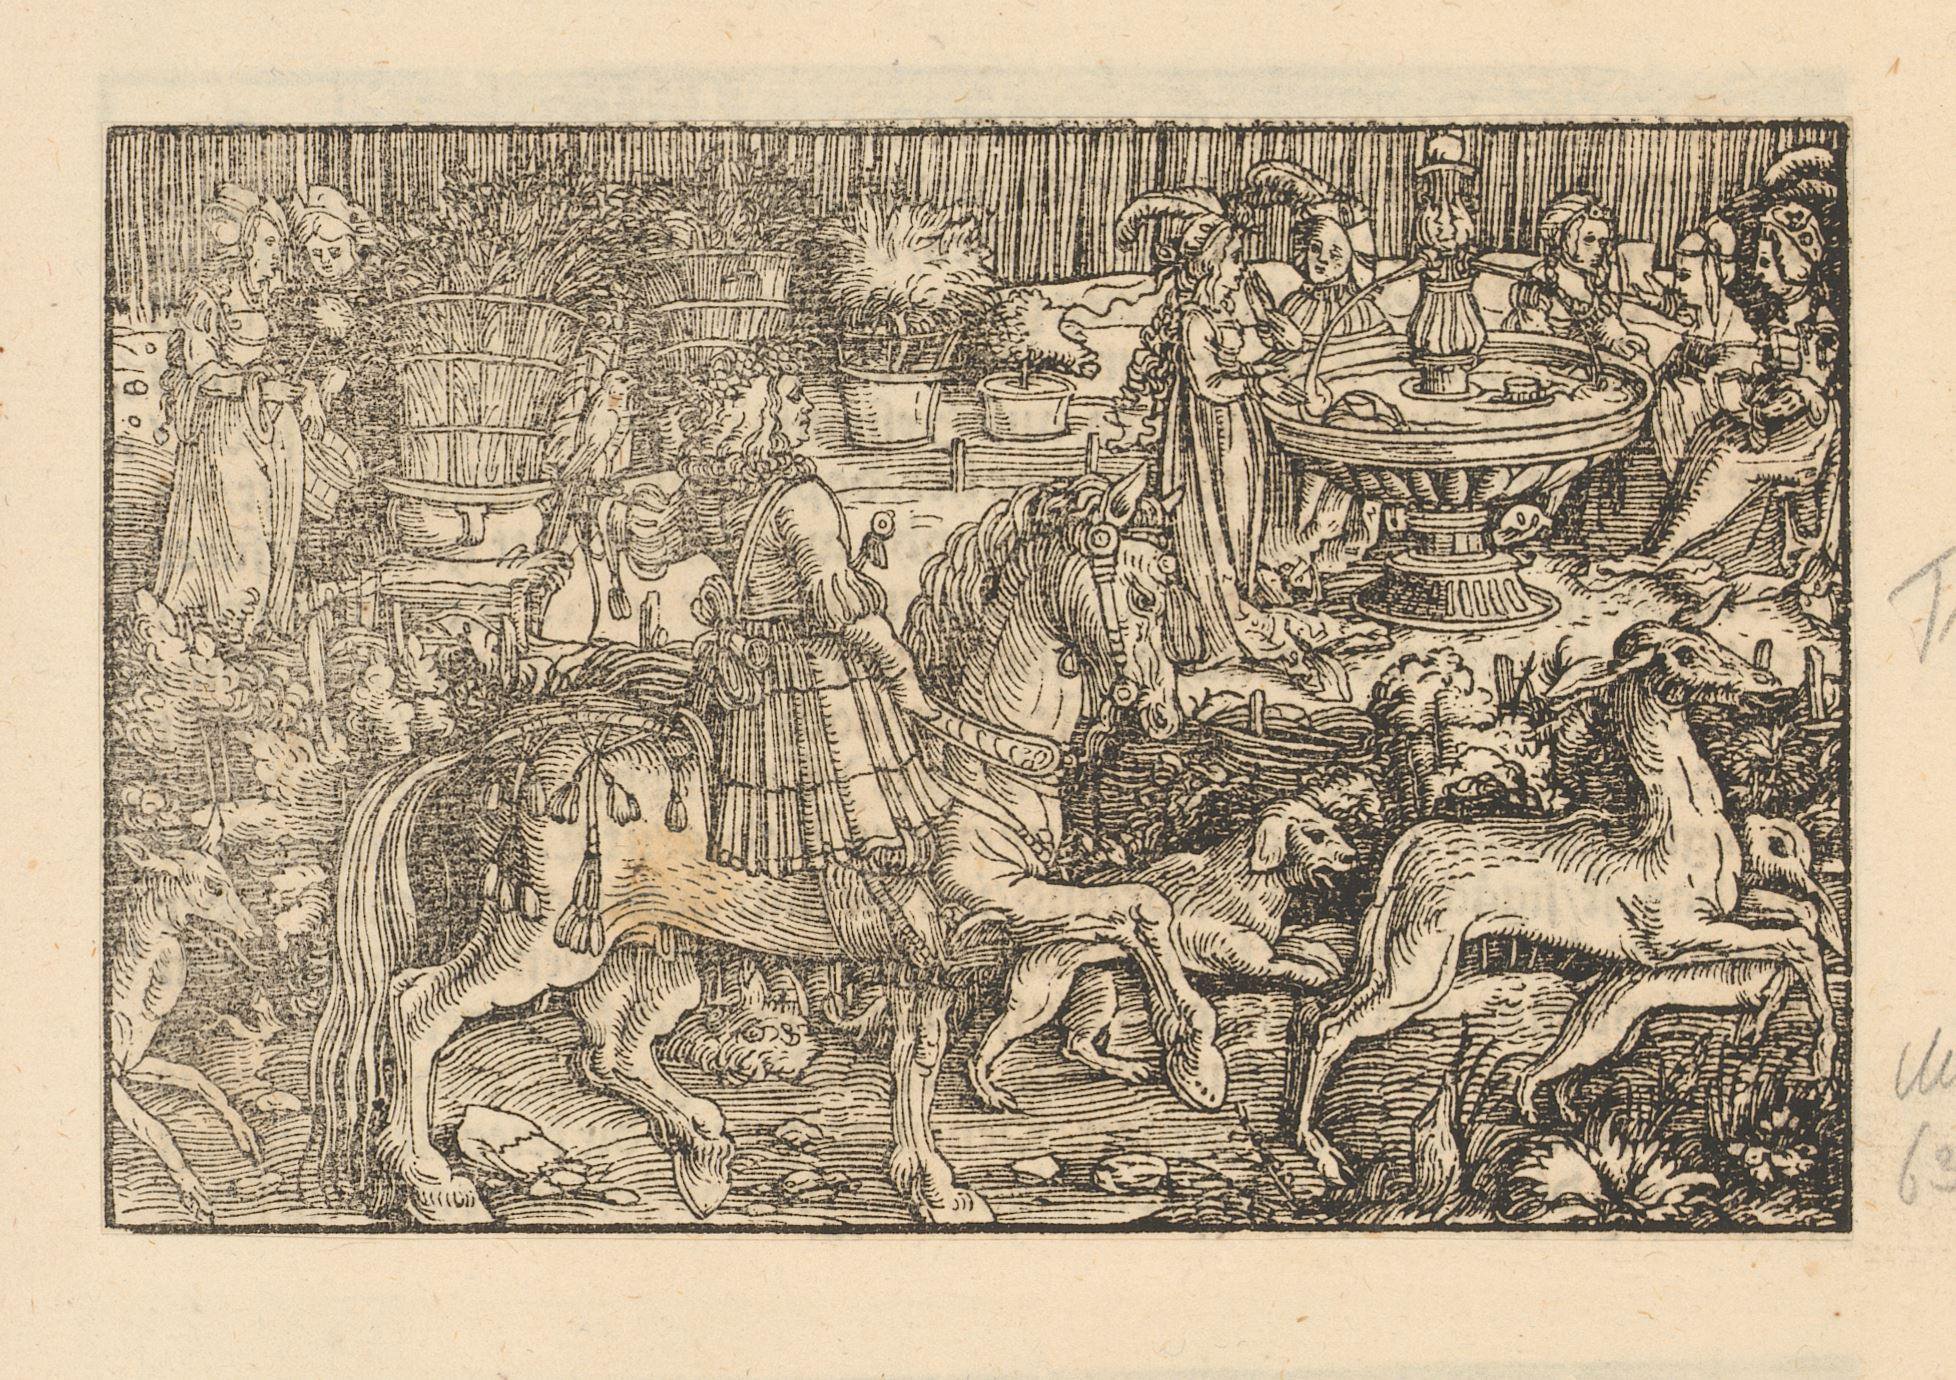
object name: print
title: Ruiter met wilde dieren bij een binnentuin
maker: Anonymous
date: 1514-1532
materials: paper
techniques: letterpress printing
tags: riding a horse, ass, or mule; rider, horseman, garden, garden fountain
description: Deze prent is gebruikt in: Petrarca, Francesco. Von der Artzney bayder Glück, des guten und widerwertigen: unnd weß sich ain yeder inn Gelück und Unglück halten sol (...). Augsburg: Heinrich Steiner, 1532. Deze uitgave is ook bekend onder de titel 'Trostspiegel in Glück und Unglück'.